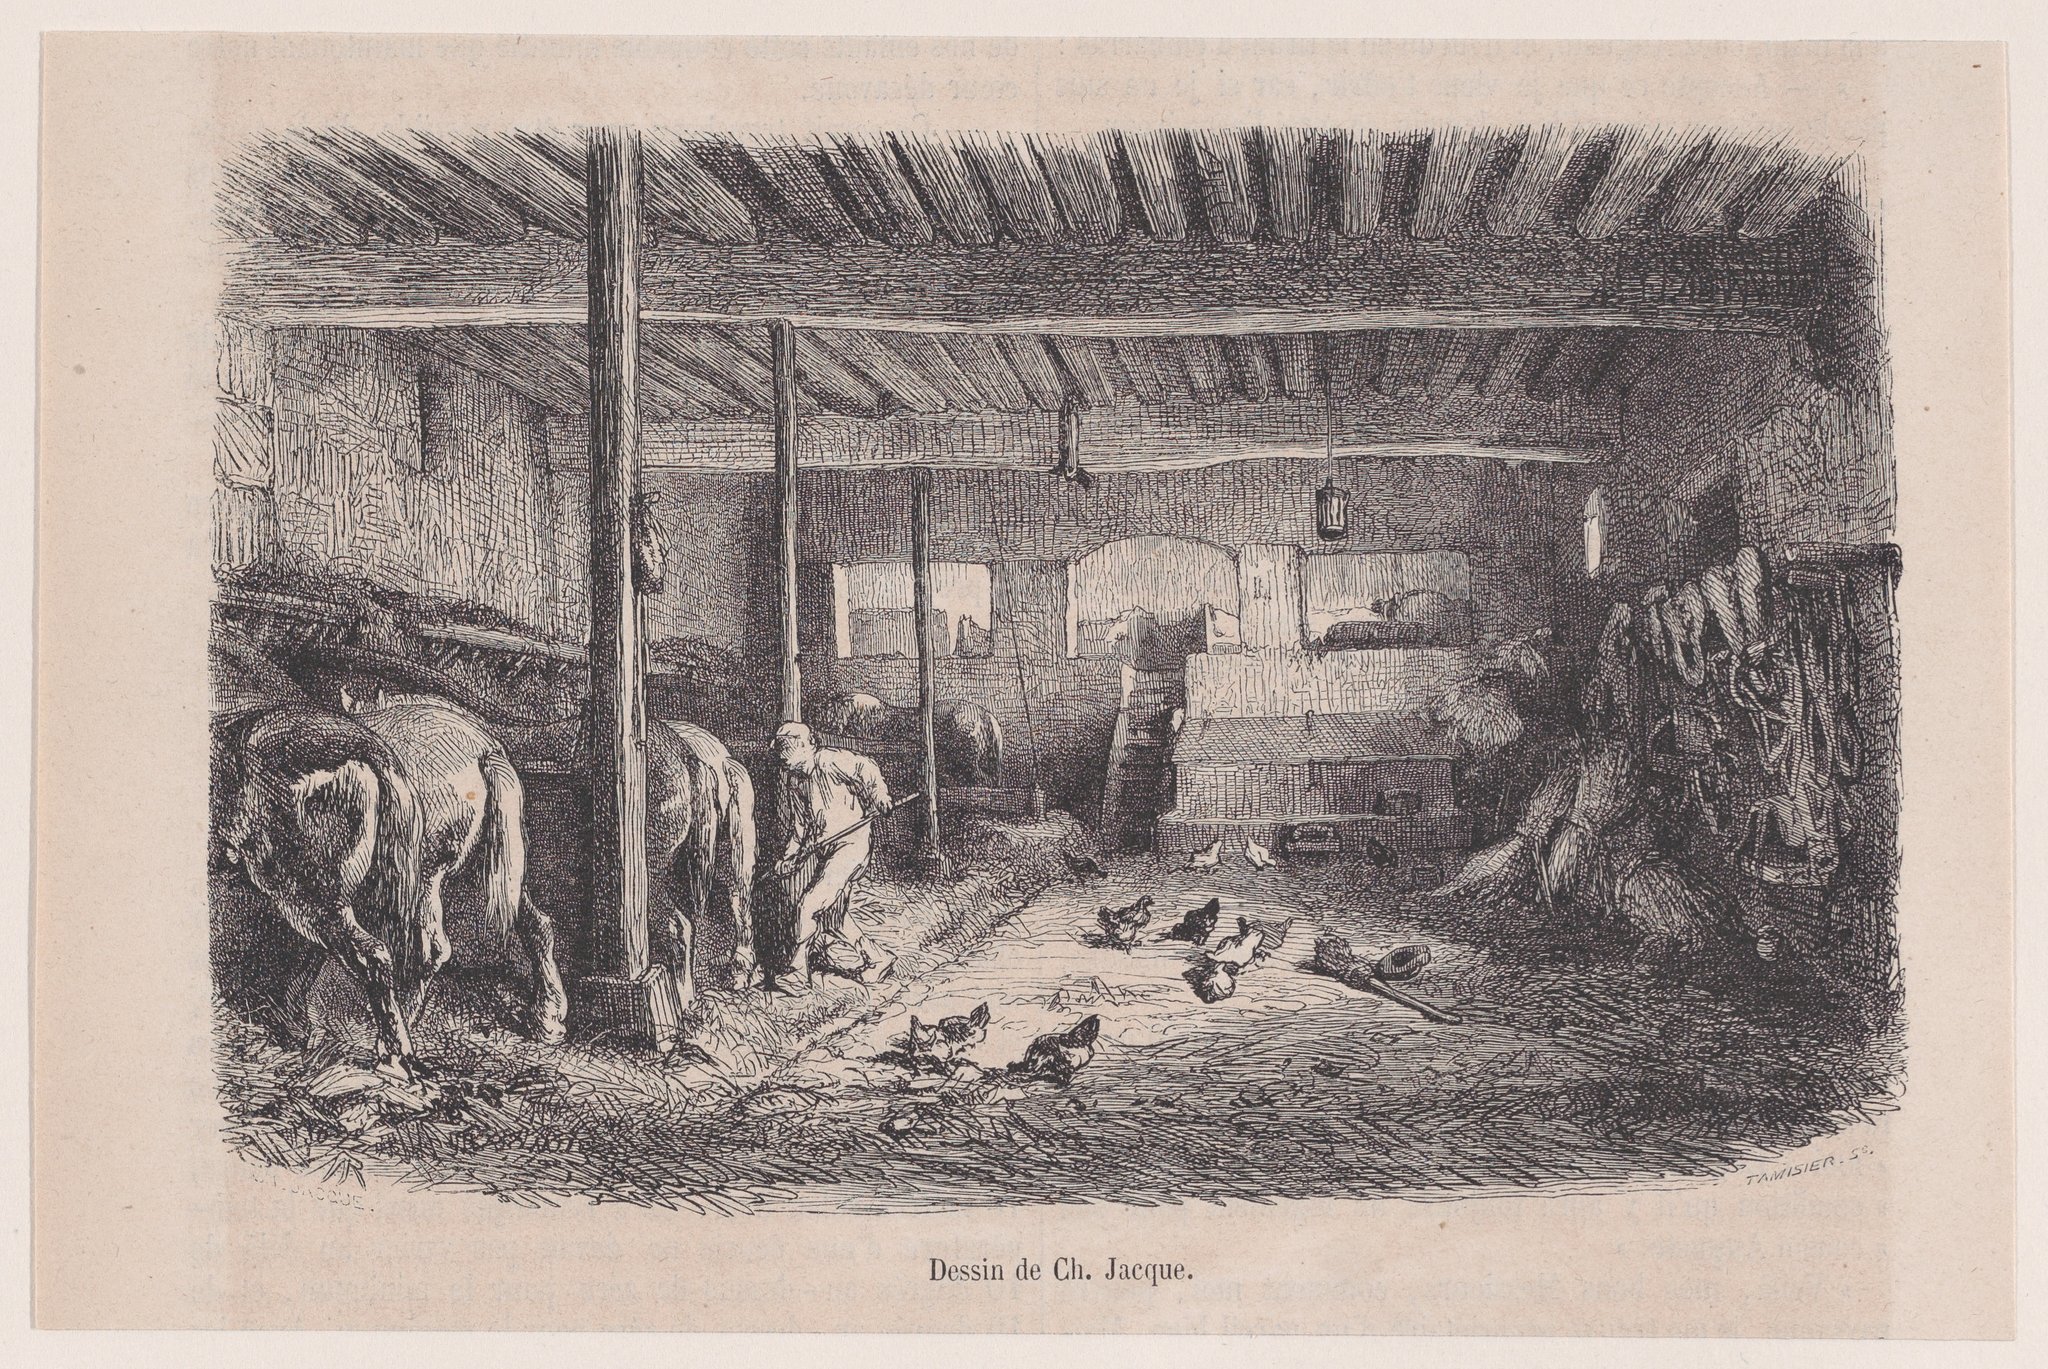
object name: print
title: A Stable, from "Le Magasin Pittoresque"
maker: charles émile jacque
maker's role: artist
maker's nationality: french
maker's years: 1813-1894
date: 1852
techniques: engraving